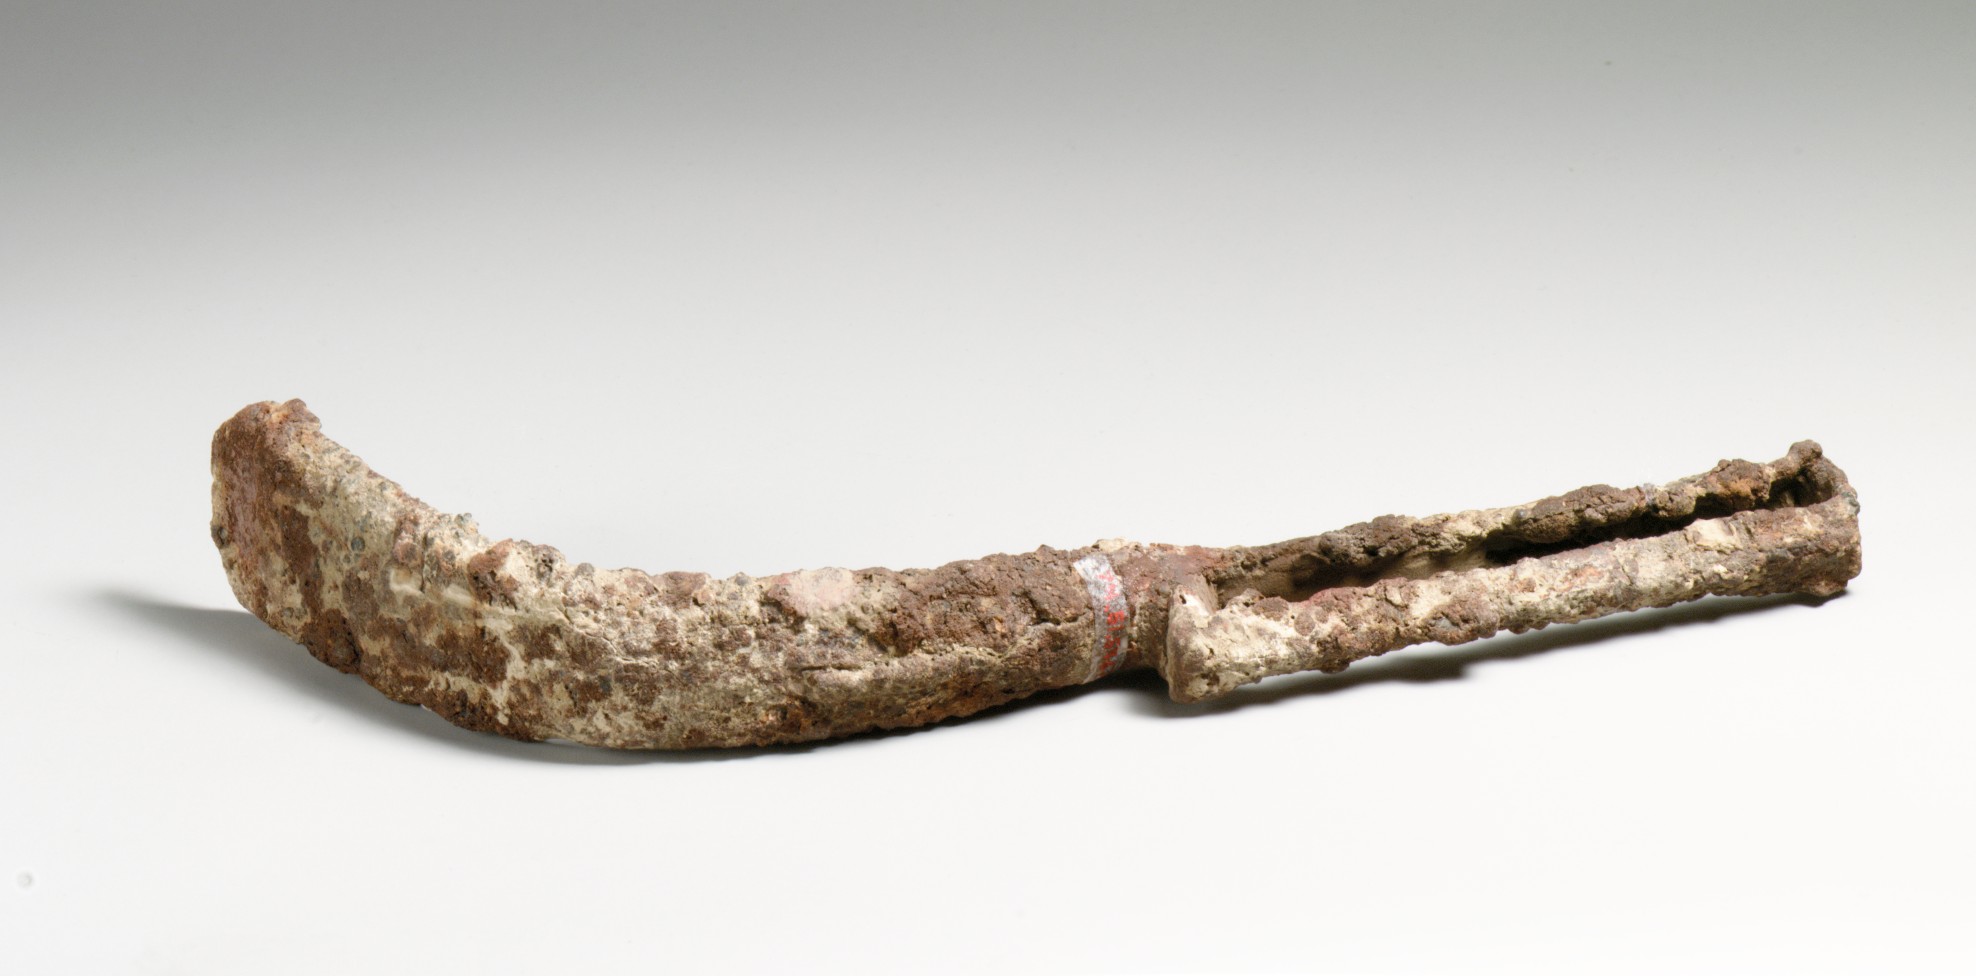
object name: strigil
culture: cypriot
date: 3900 BCE-100 CE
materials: iron